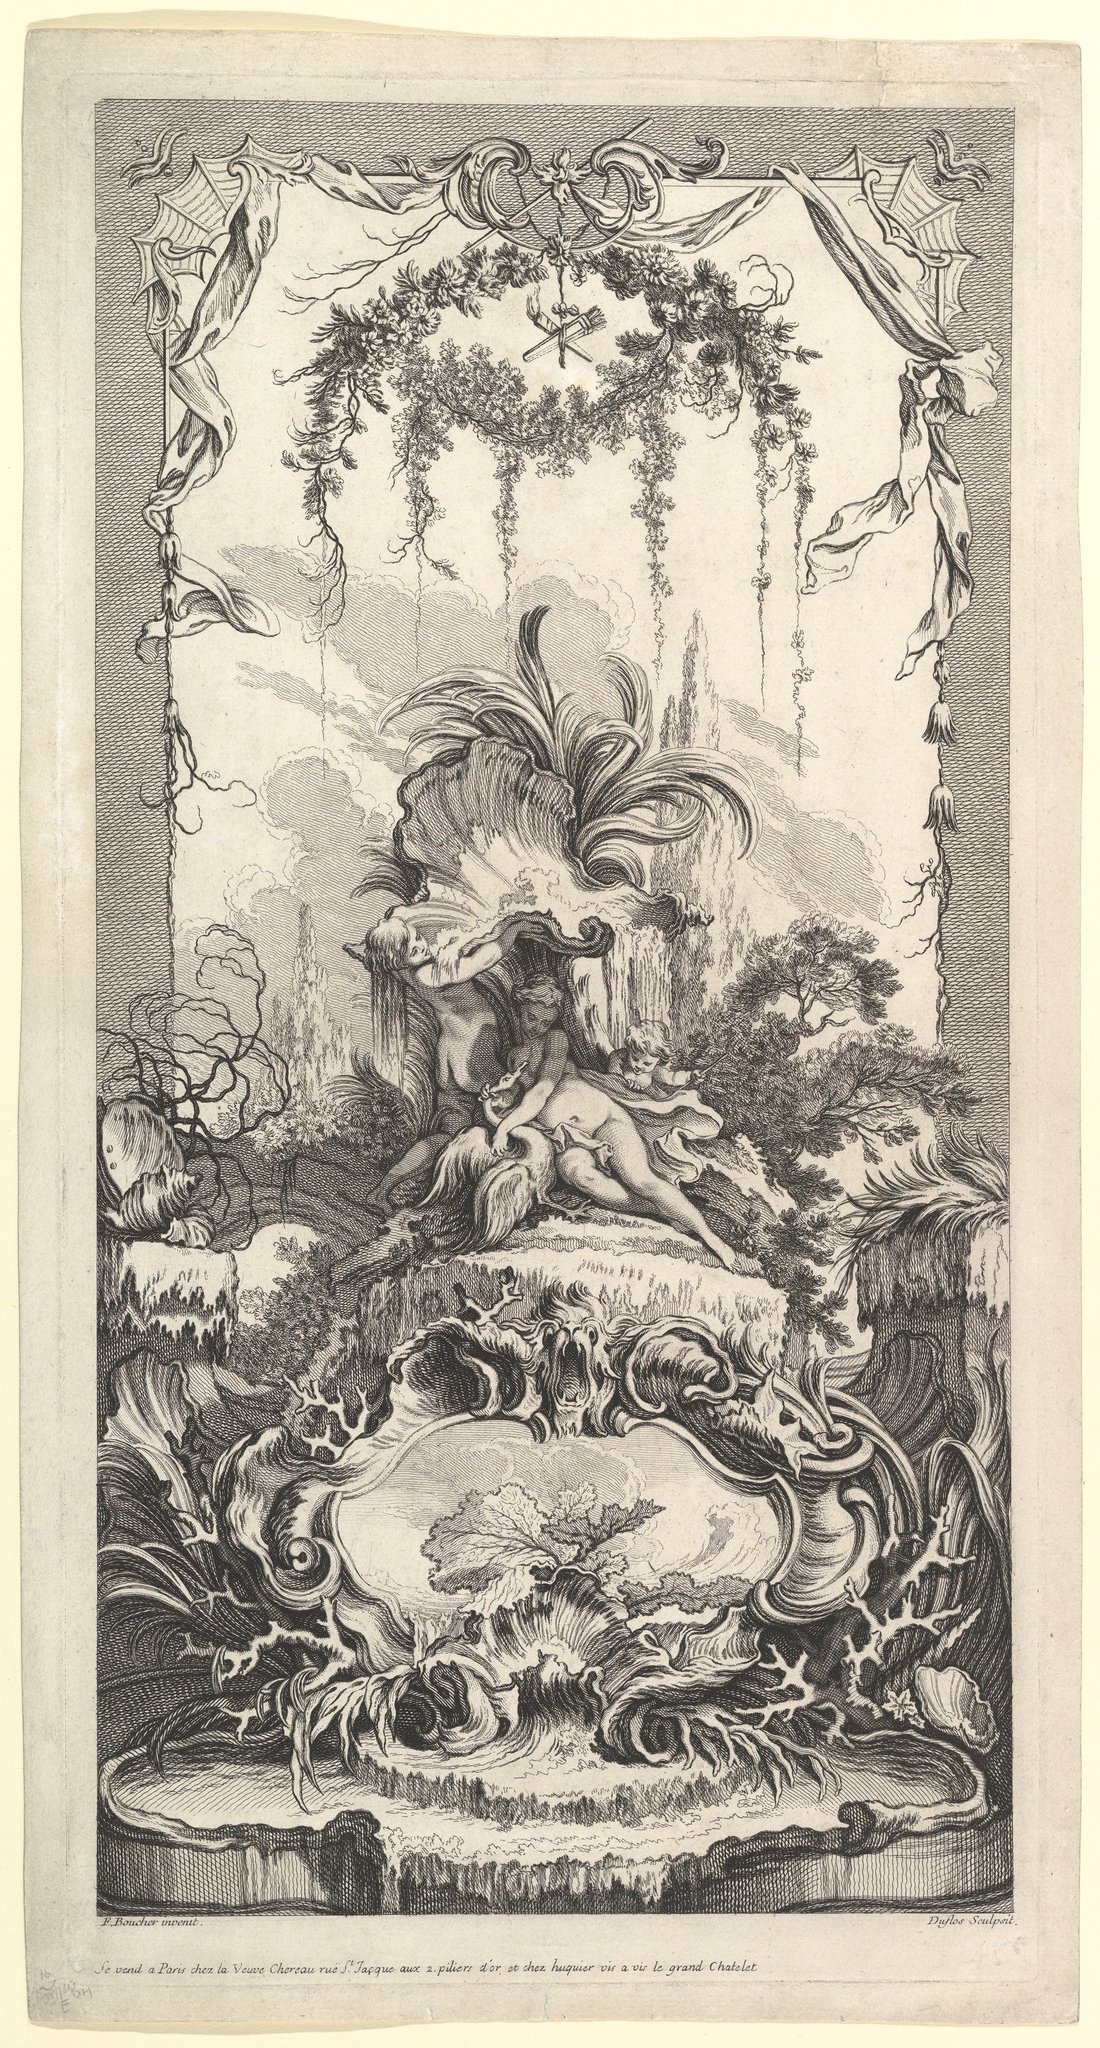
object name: print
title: Leda and the Swan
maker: claude augustin duflos le jeune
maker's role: artist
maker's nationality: french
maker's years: 1700-1786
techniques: etching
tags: leda,swans